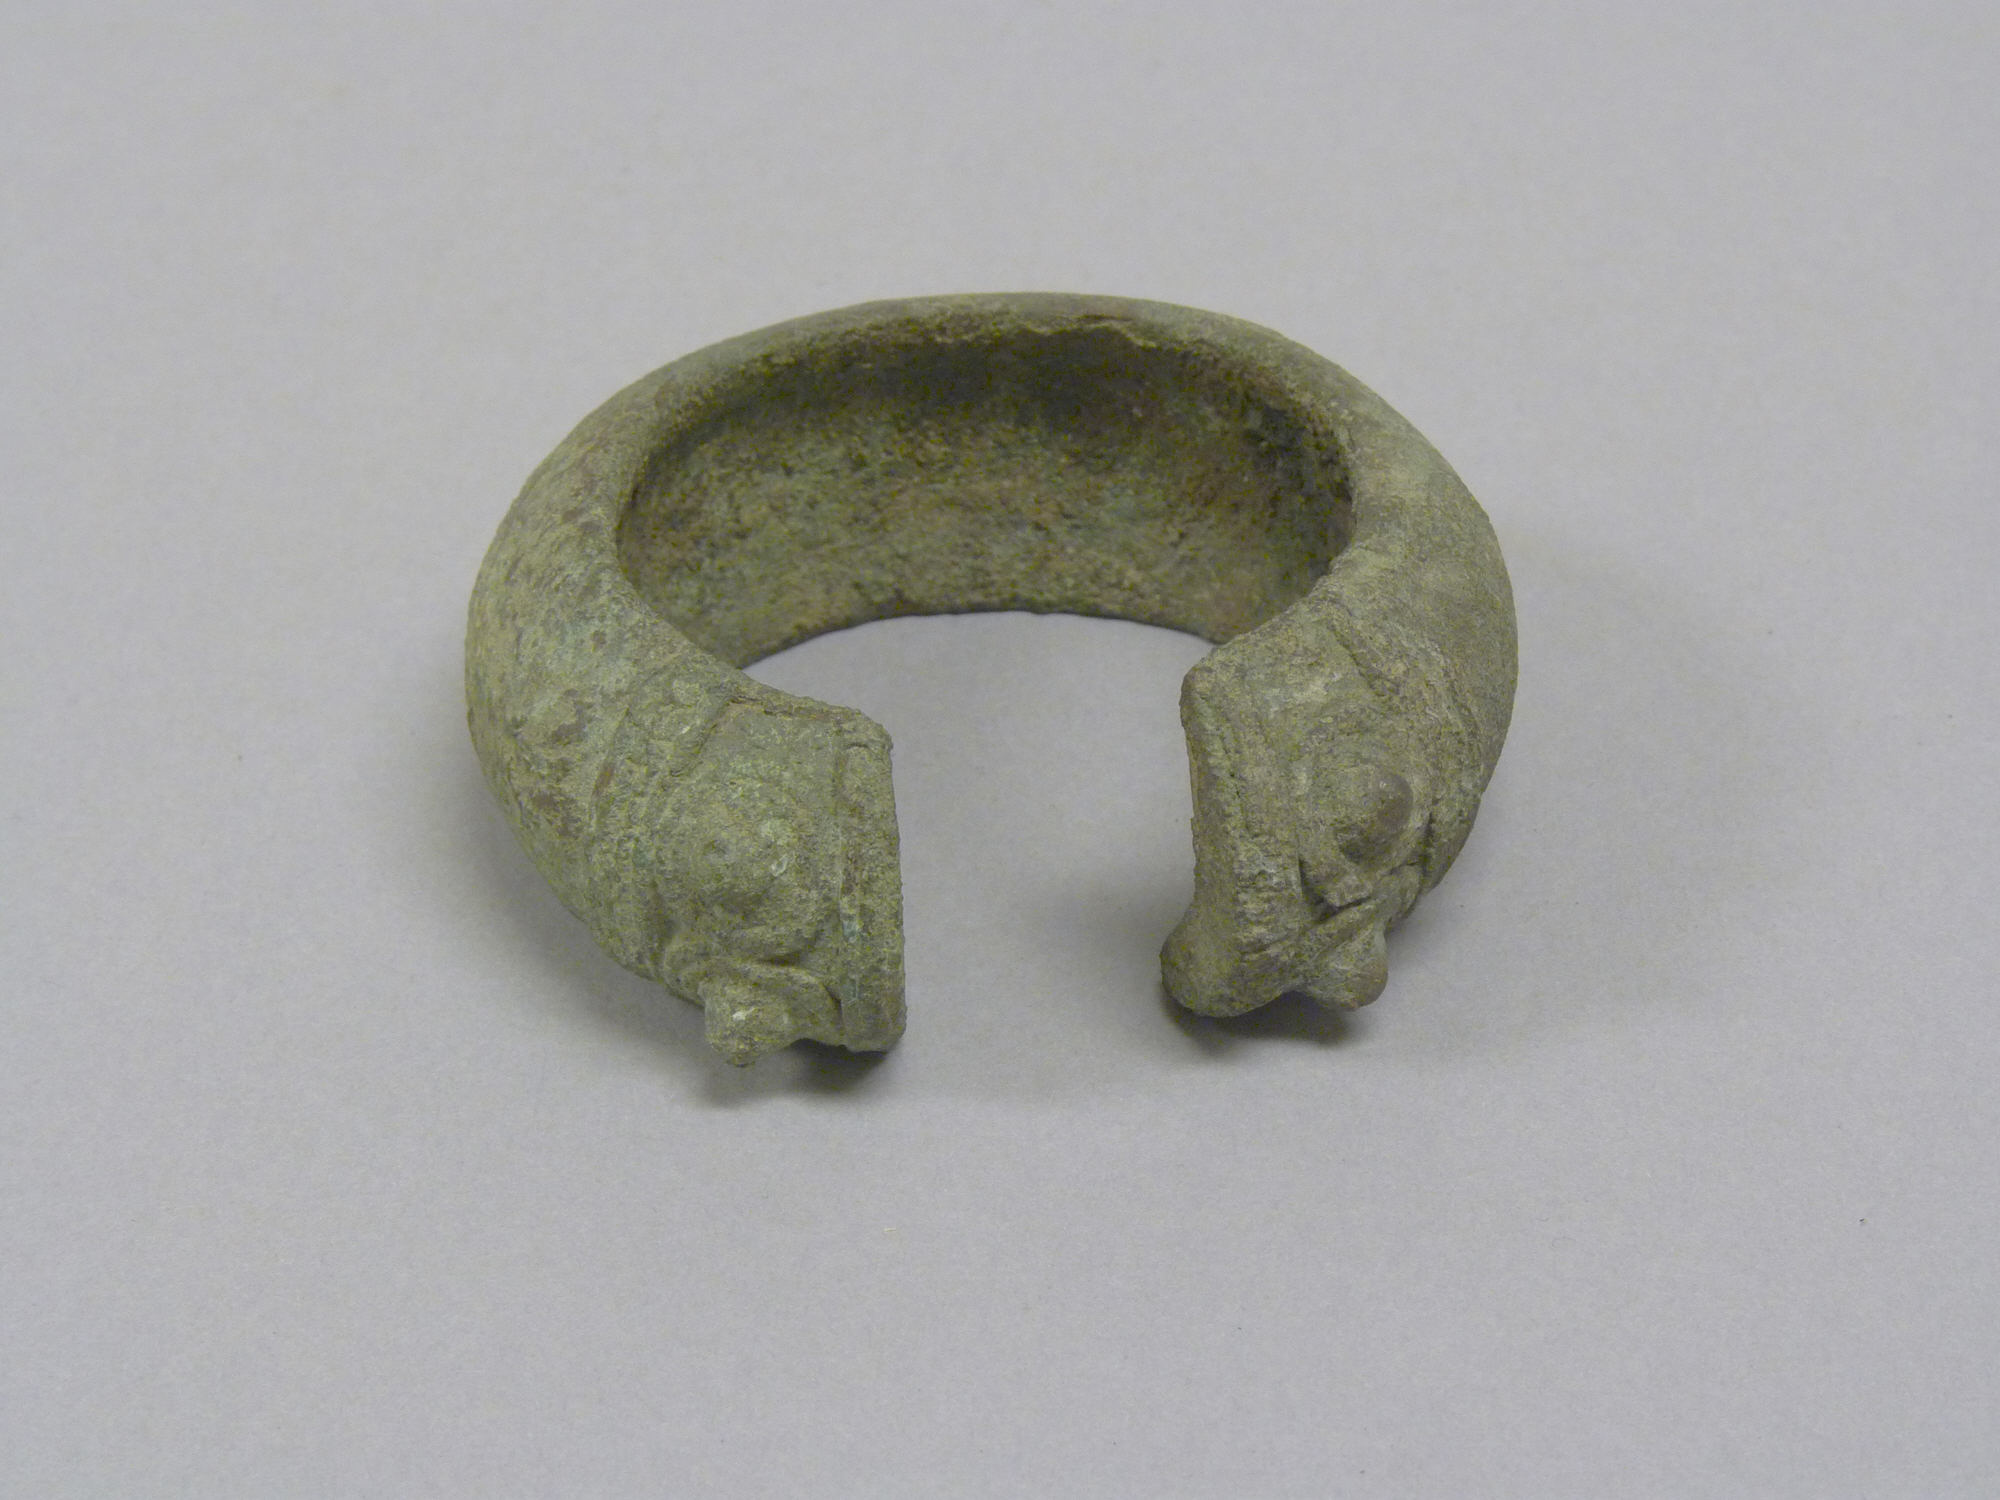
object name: bracelet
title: One From a Pair of Bracelets with Wide Open Ends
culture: thai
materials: bronze